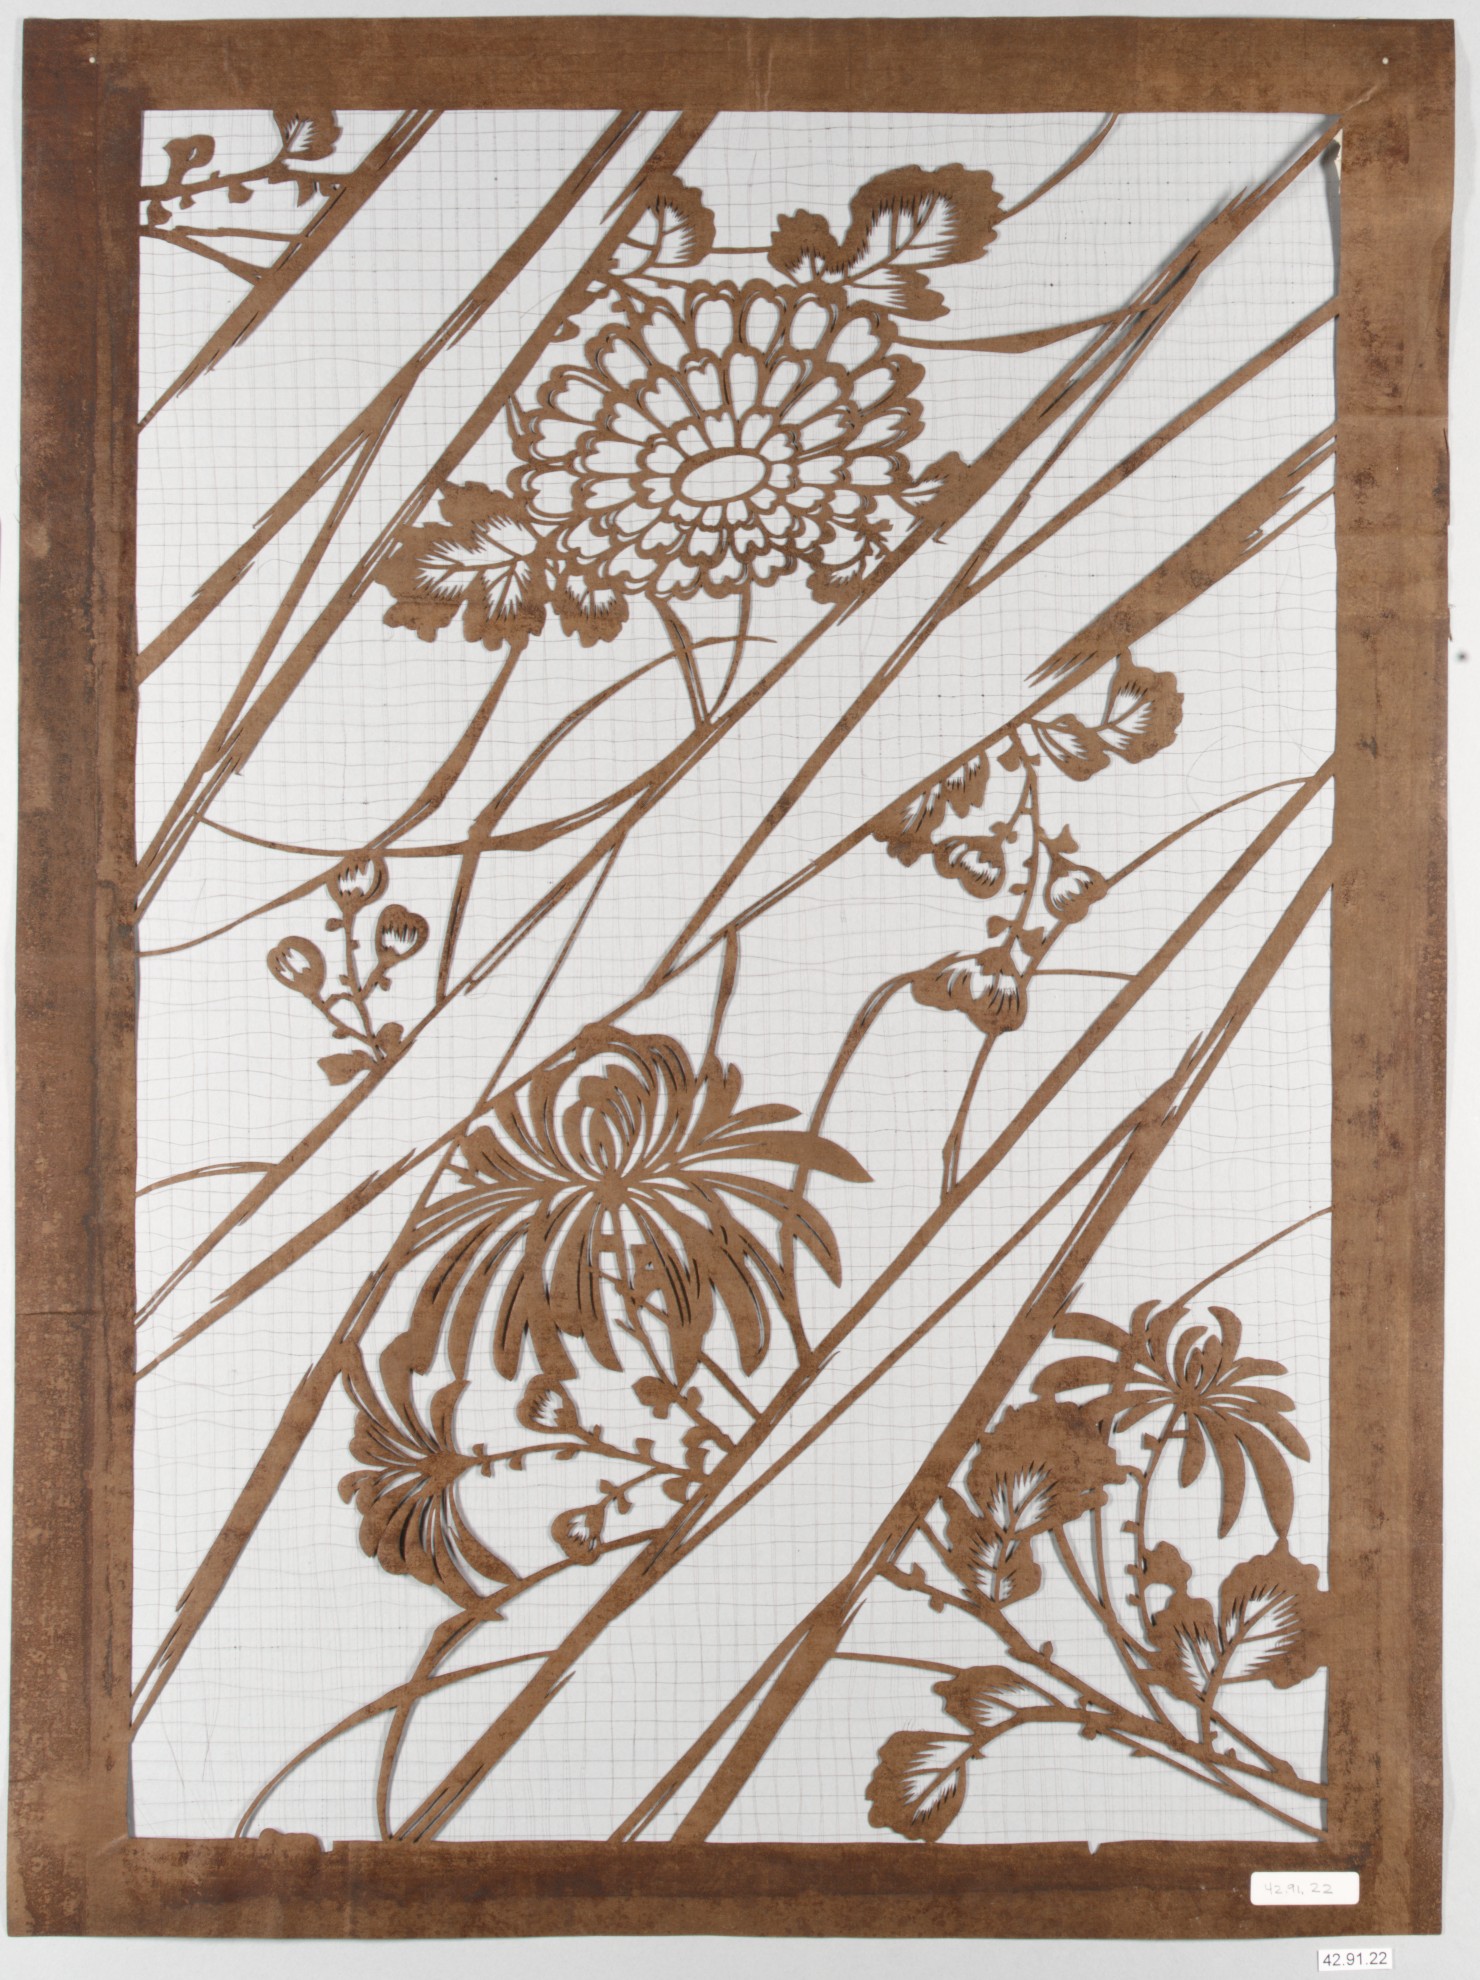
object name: stencil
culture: japanese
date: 1801-1900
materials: paper, silk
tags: flowers